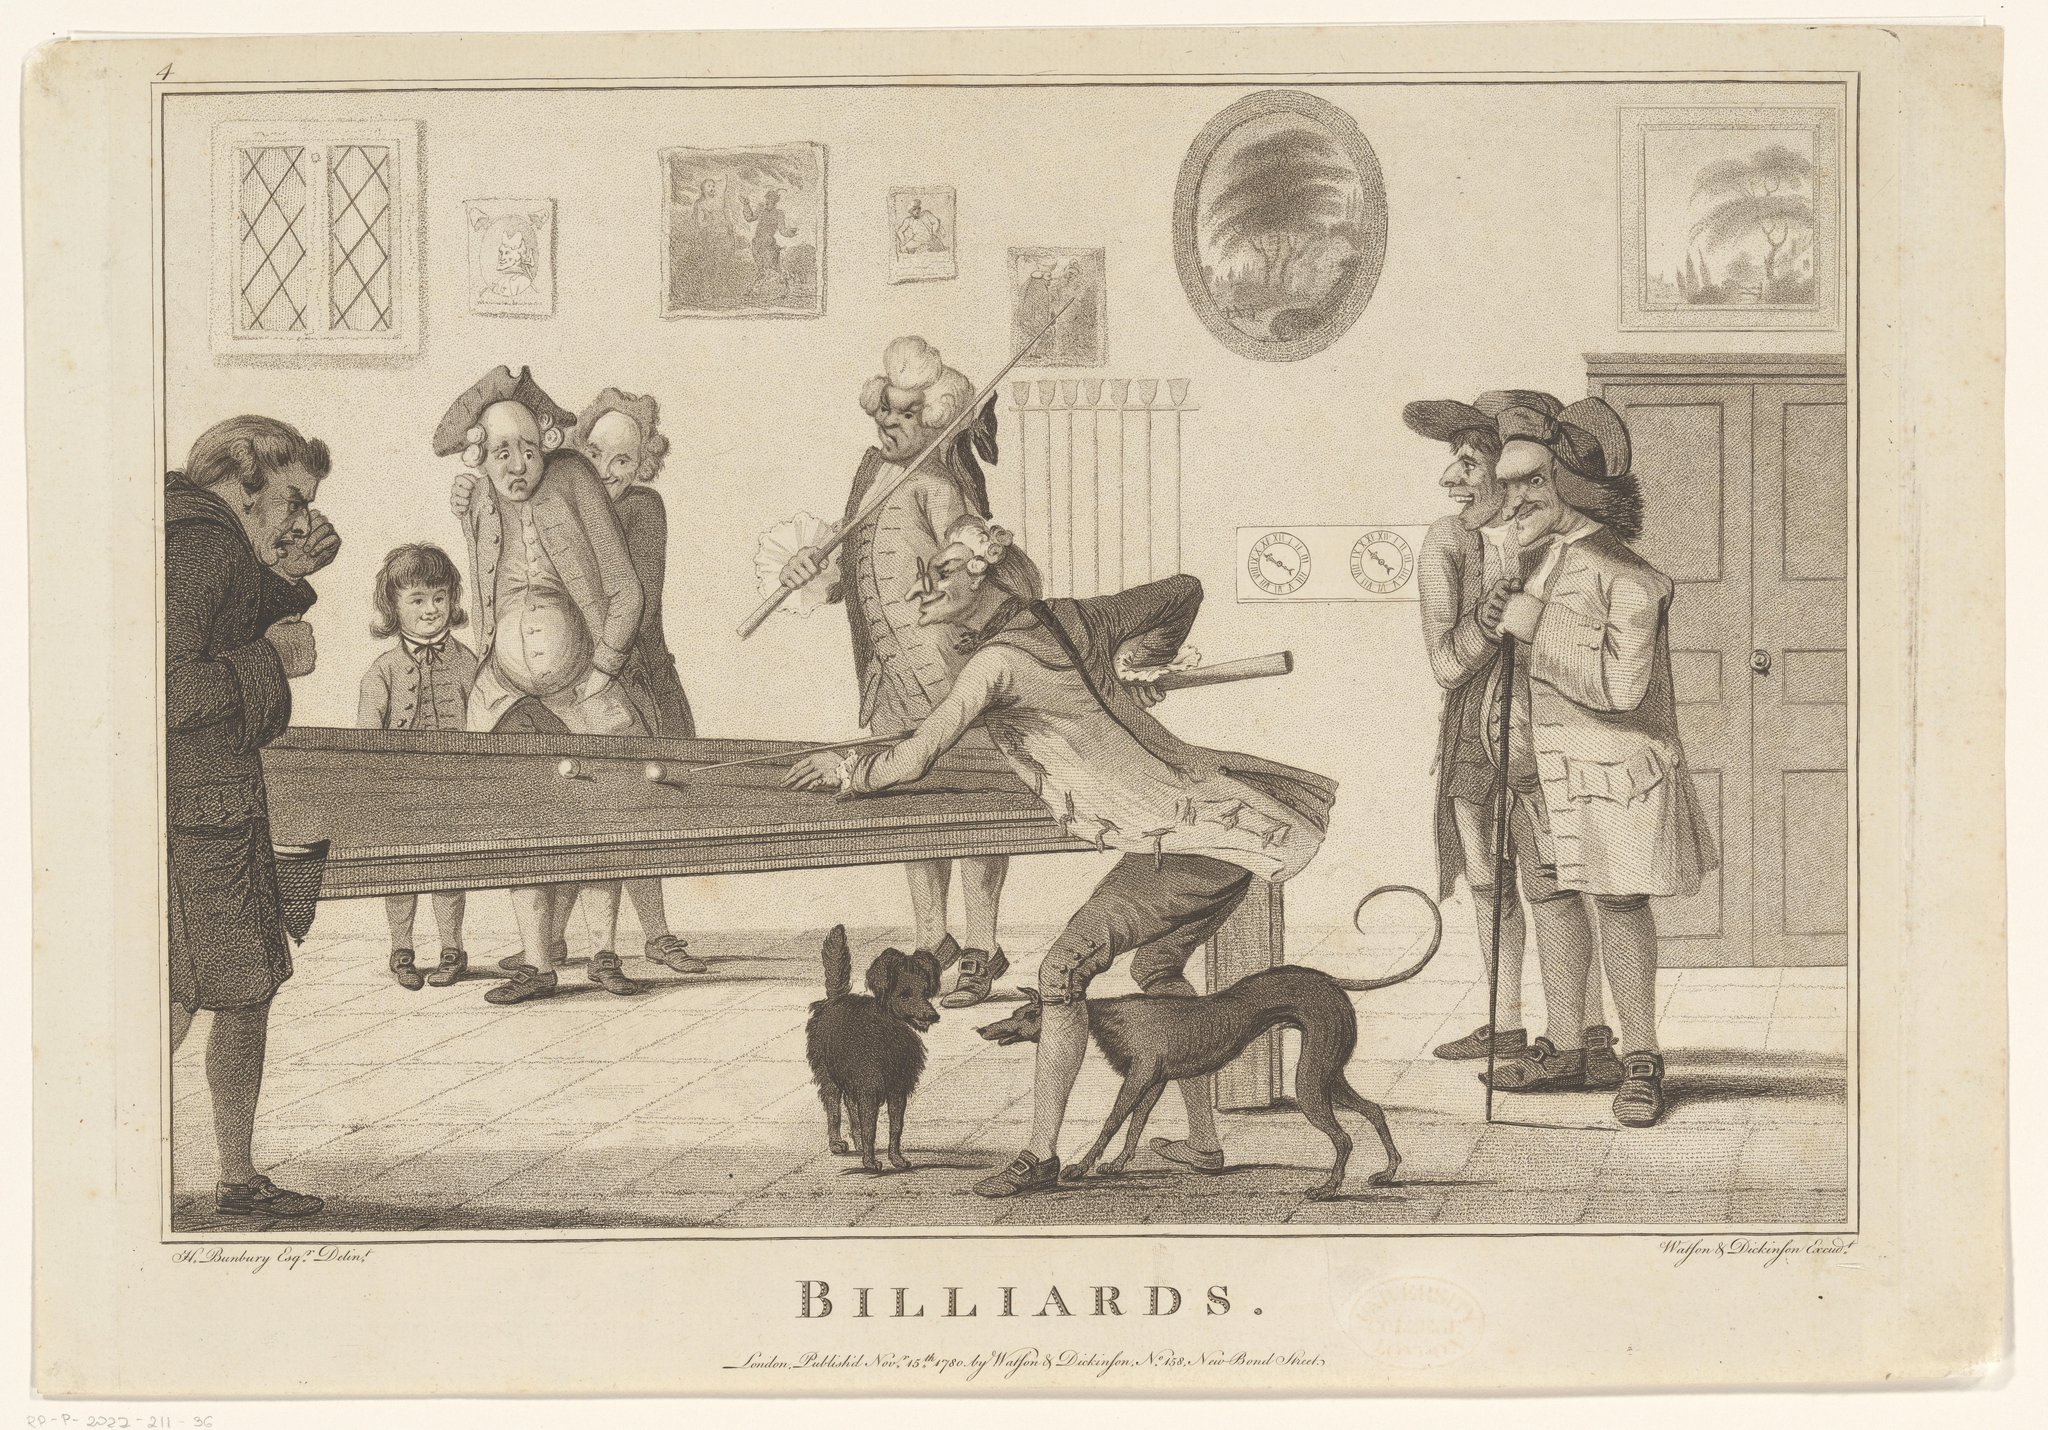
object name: cartoon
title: Een potje Biljart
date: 1780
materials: paper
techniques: etching, engraving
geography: europe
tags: billiards, caricatures (human types)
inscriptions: collector's mark: Lugt 2228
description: Twee mannen spelen biljart terwijl andere mannen gespannen toekijken. De biljarttafel lijkt driehoekig van vorm. Prent nummer 4 uit een serie.